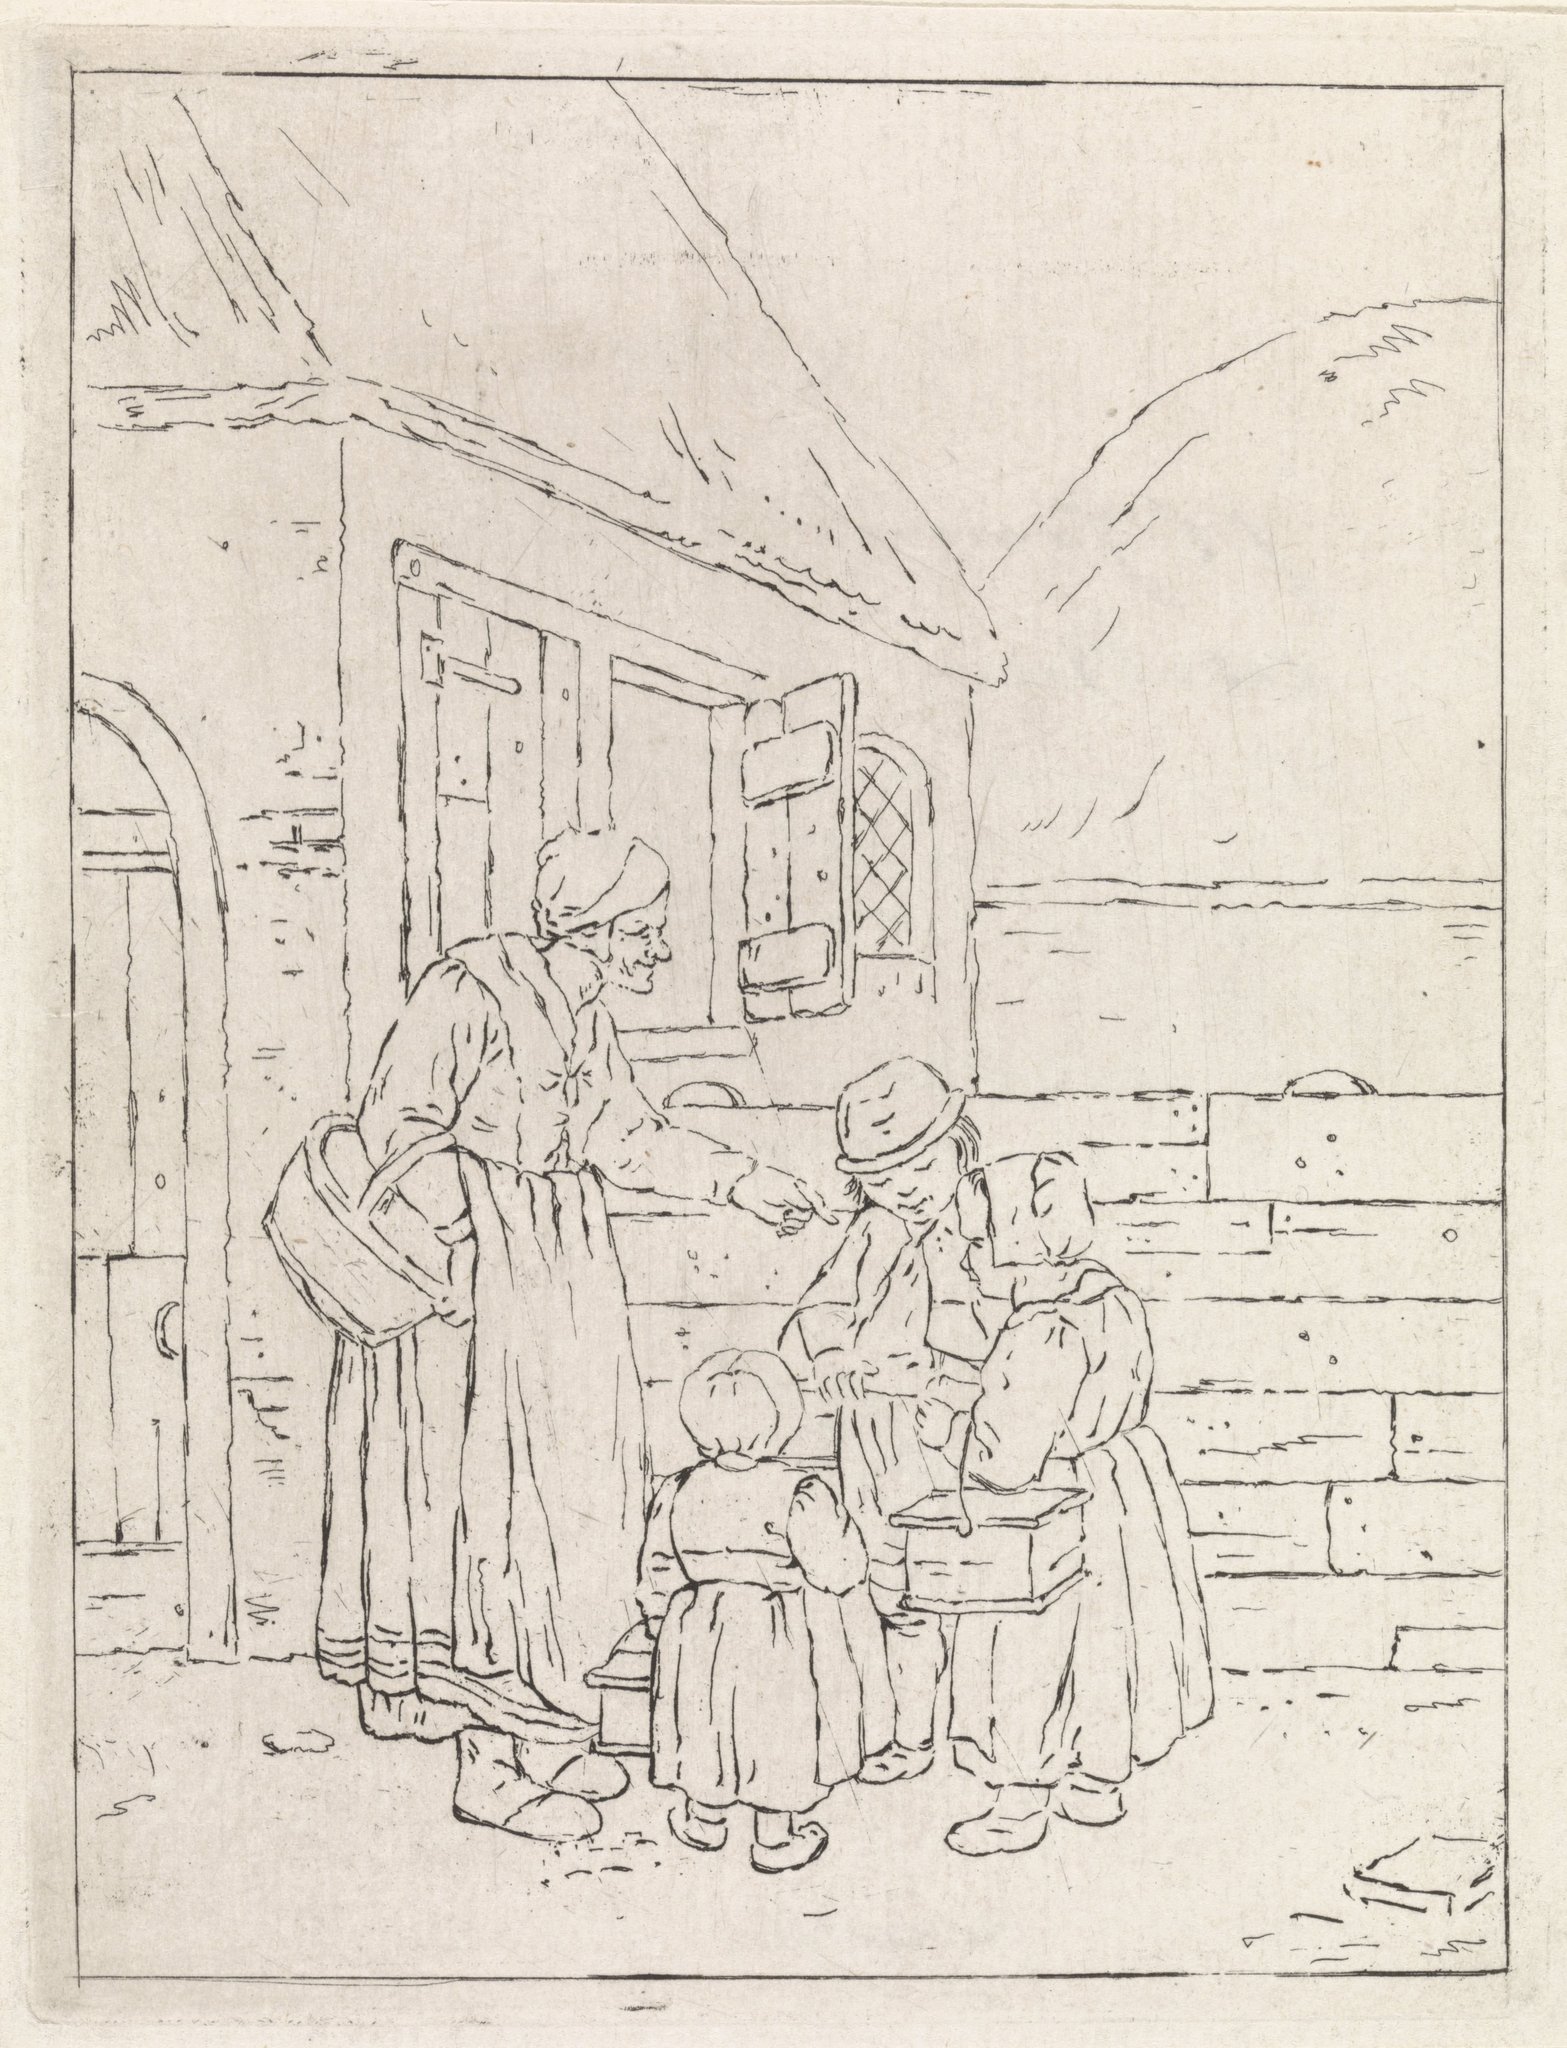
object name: print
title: Erf met oude vrouw en drie kinderen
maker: johannes christiaan janson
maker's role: draughtsman, painter, print maker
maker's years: 1763-1823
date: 1778-1823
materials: paper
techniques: etching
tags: foot-stove, farmers, farm or solitary house in landscape, mother and child(ren), woman and child(ren) (family group) (with number of children)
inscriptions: inscription: ‘M’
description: Erf met vermoedelijk een boerderij, een oude vrouw en drie kinderen. De vrouw draagt een mand en de drie kinderen waarschijnlijk voetstoofjes (hier nog niet helemaal uitgewerkt, maar te zien aan de gaten op RP-P-1918-1860 en RP-P-1918-1861).